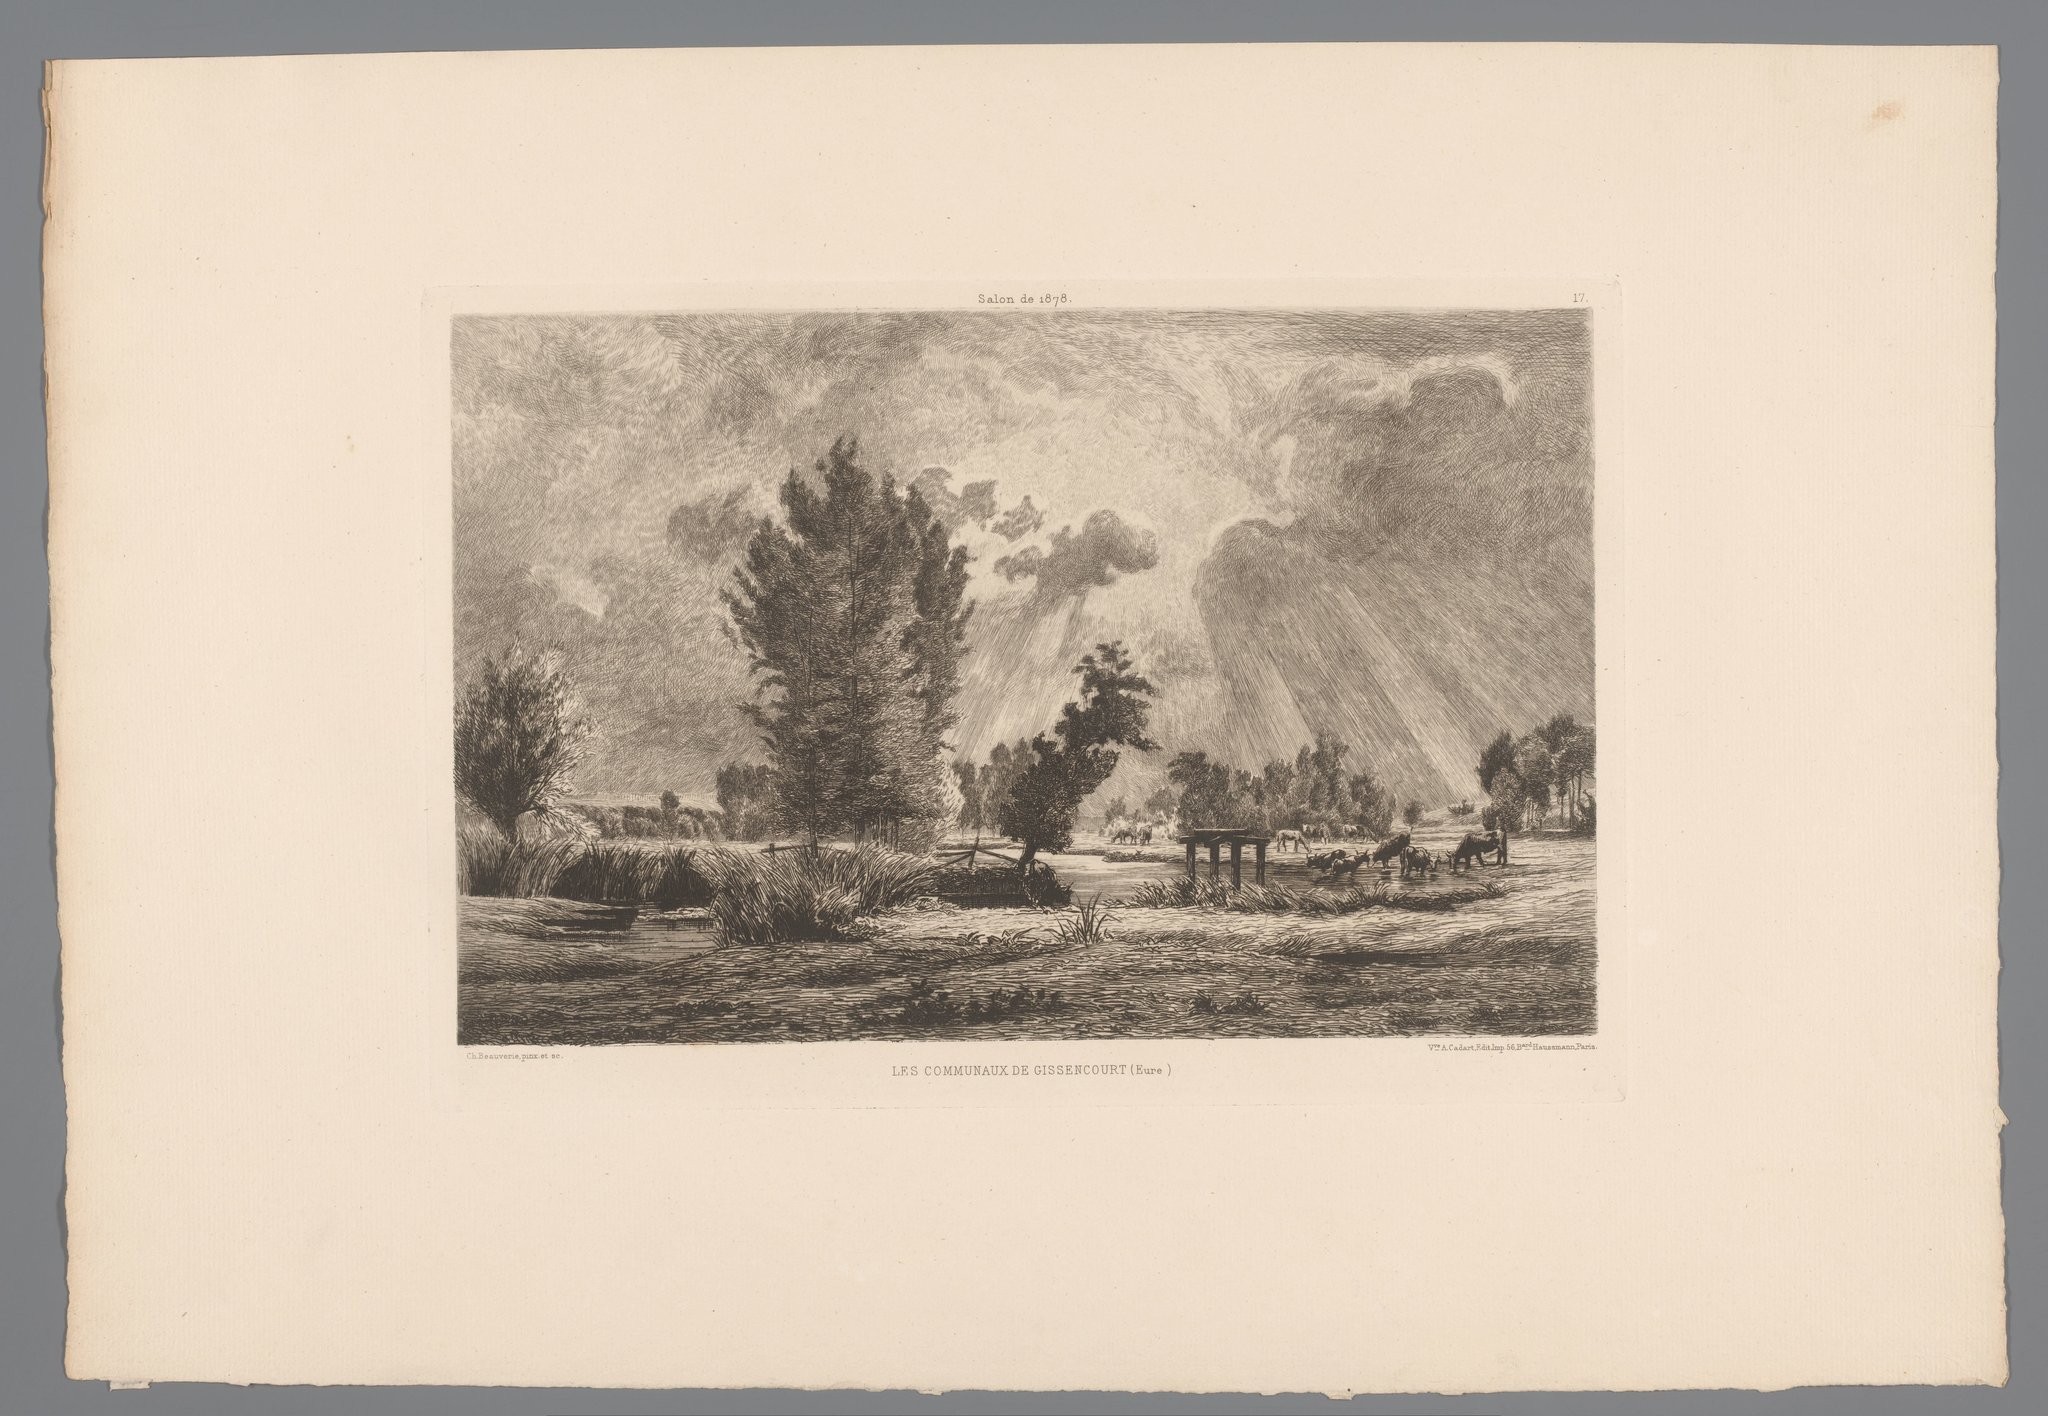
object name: print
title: Landschap met drinkende koeien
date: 1879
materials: paper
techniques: drypoint, etching, intaglio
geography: paris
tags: cow, meadow, pasture, herd, flock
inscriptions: collector's mark: Lugt 2760, collector's mark: ‘AFE v S’, watermark, collector's mark: Lugt 2228